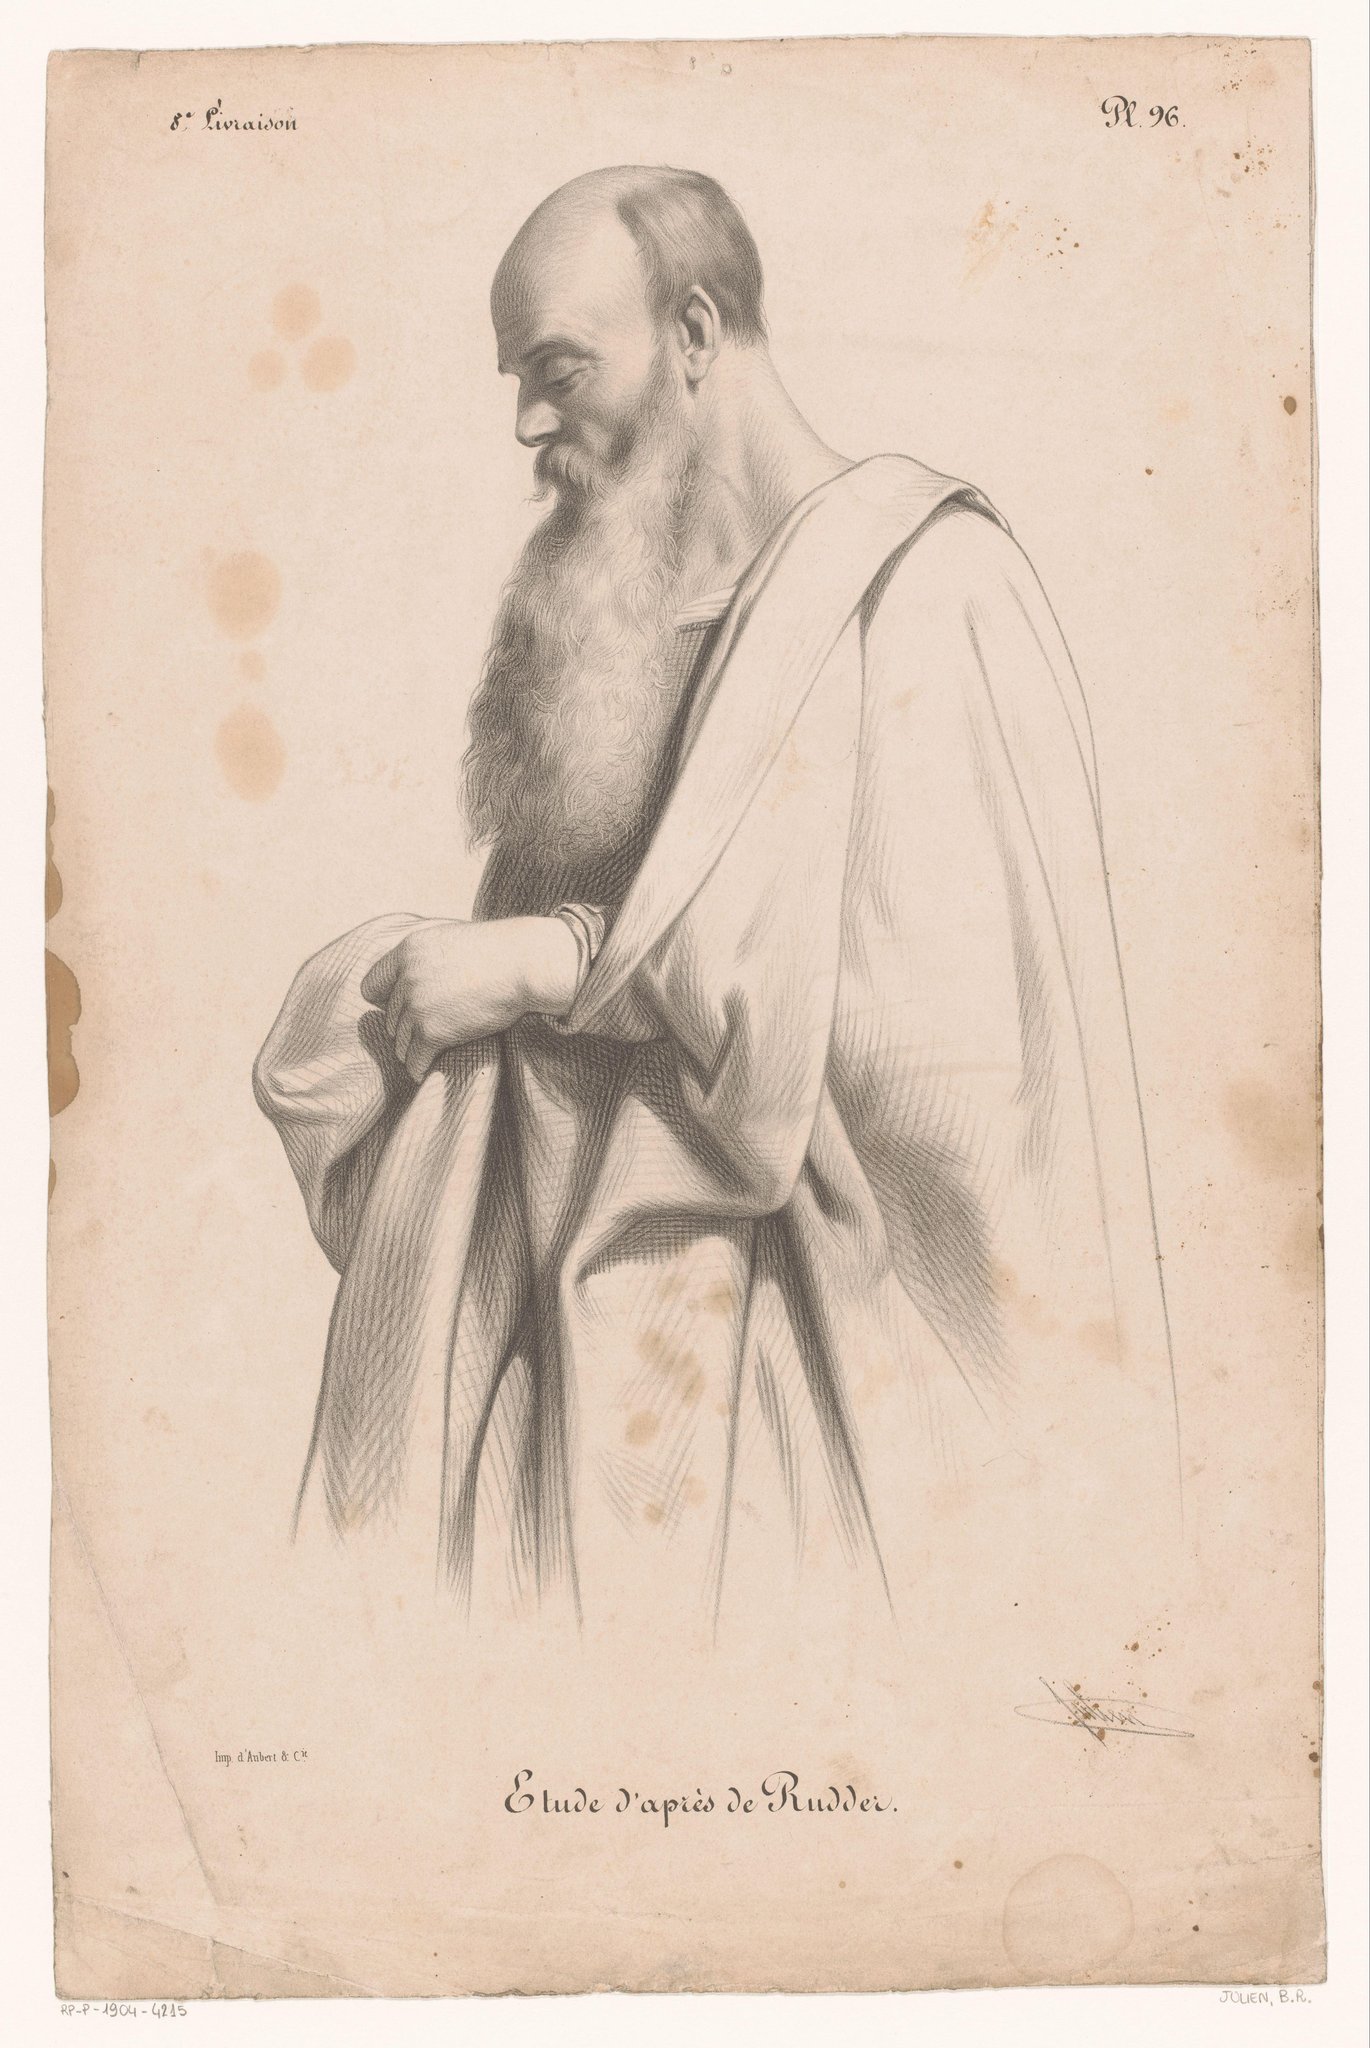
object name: print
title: Studies als tekenvoorbeeld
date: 1836-1843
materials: paper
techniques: lithograph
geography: paris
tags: saints, beard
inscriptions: collector's mark: Lugt 2228a